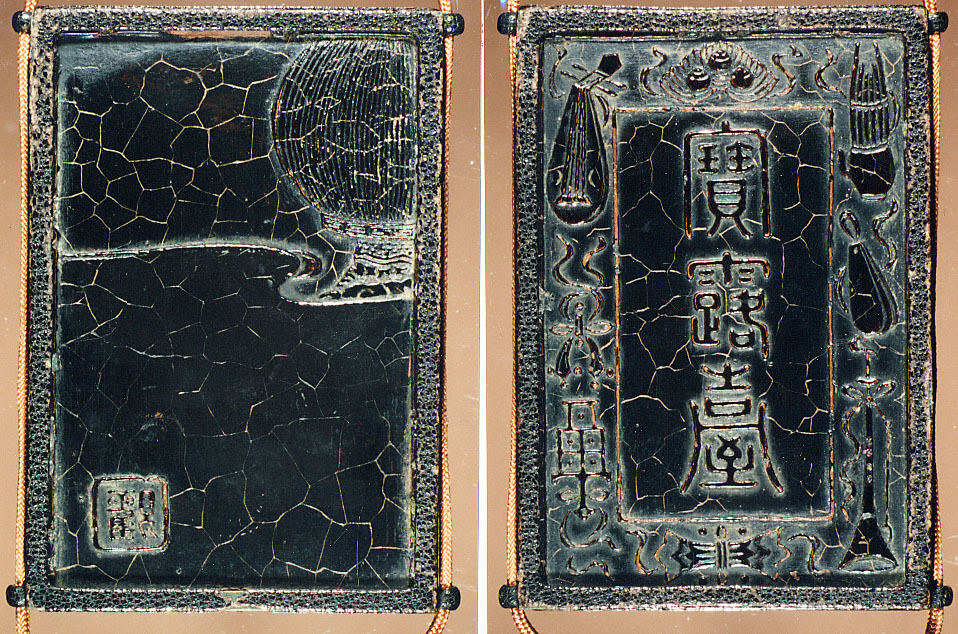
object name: inrō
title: Inrō Imitating an Old Chinese Ink Cake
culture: japanese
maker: ogawa haritsu (ritsuō)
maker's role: artist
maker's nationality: japanese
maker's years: 1663-1747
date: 1701-1800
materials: wood, ceramic, leather, metal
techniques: lacquer, maki, maki-e